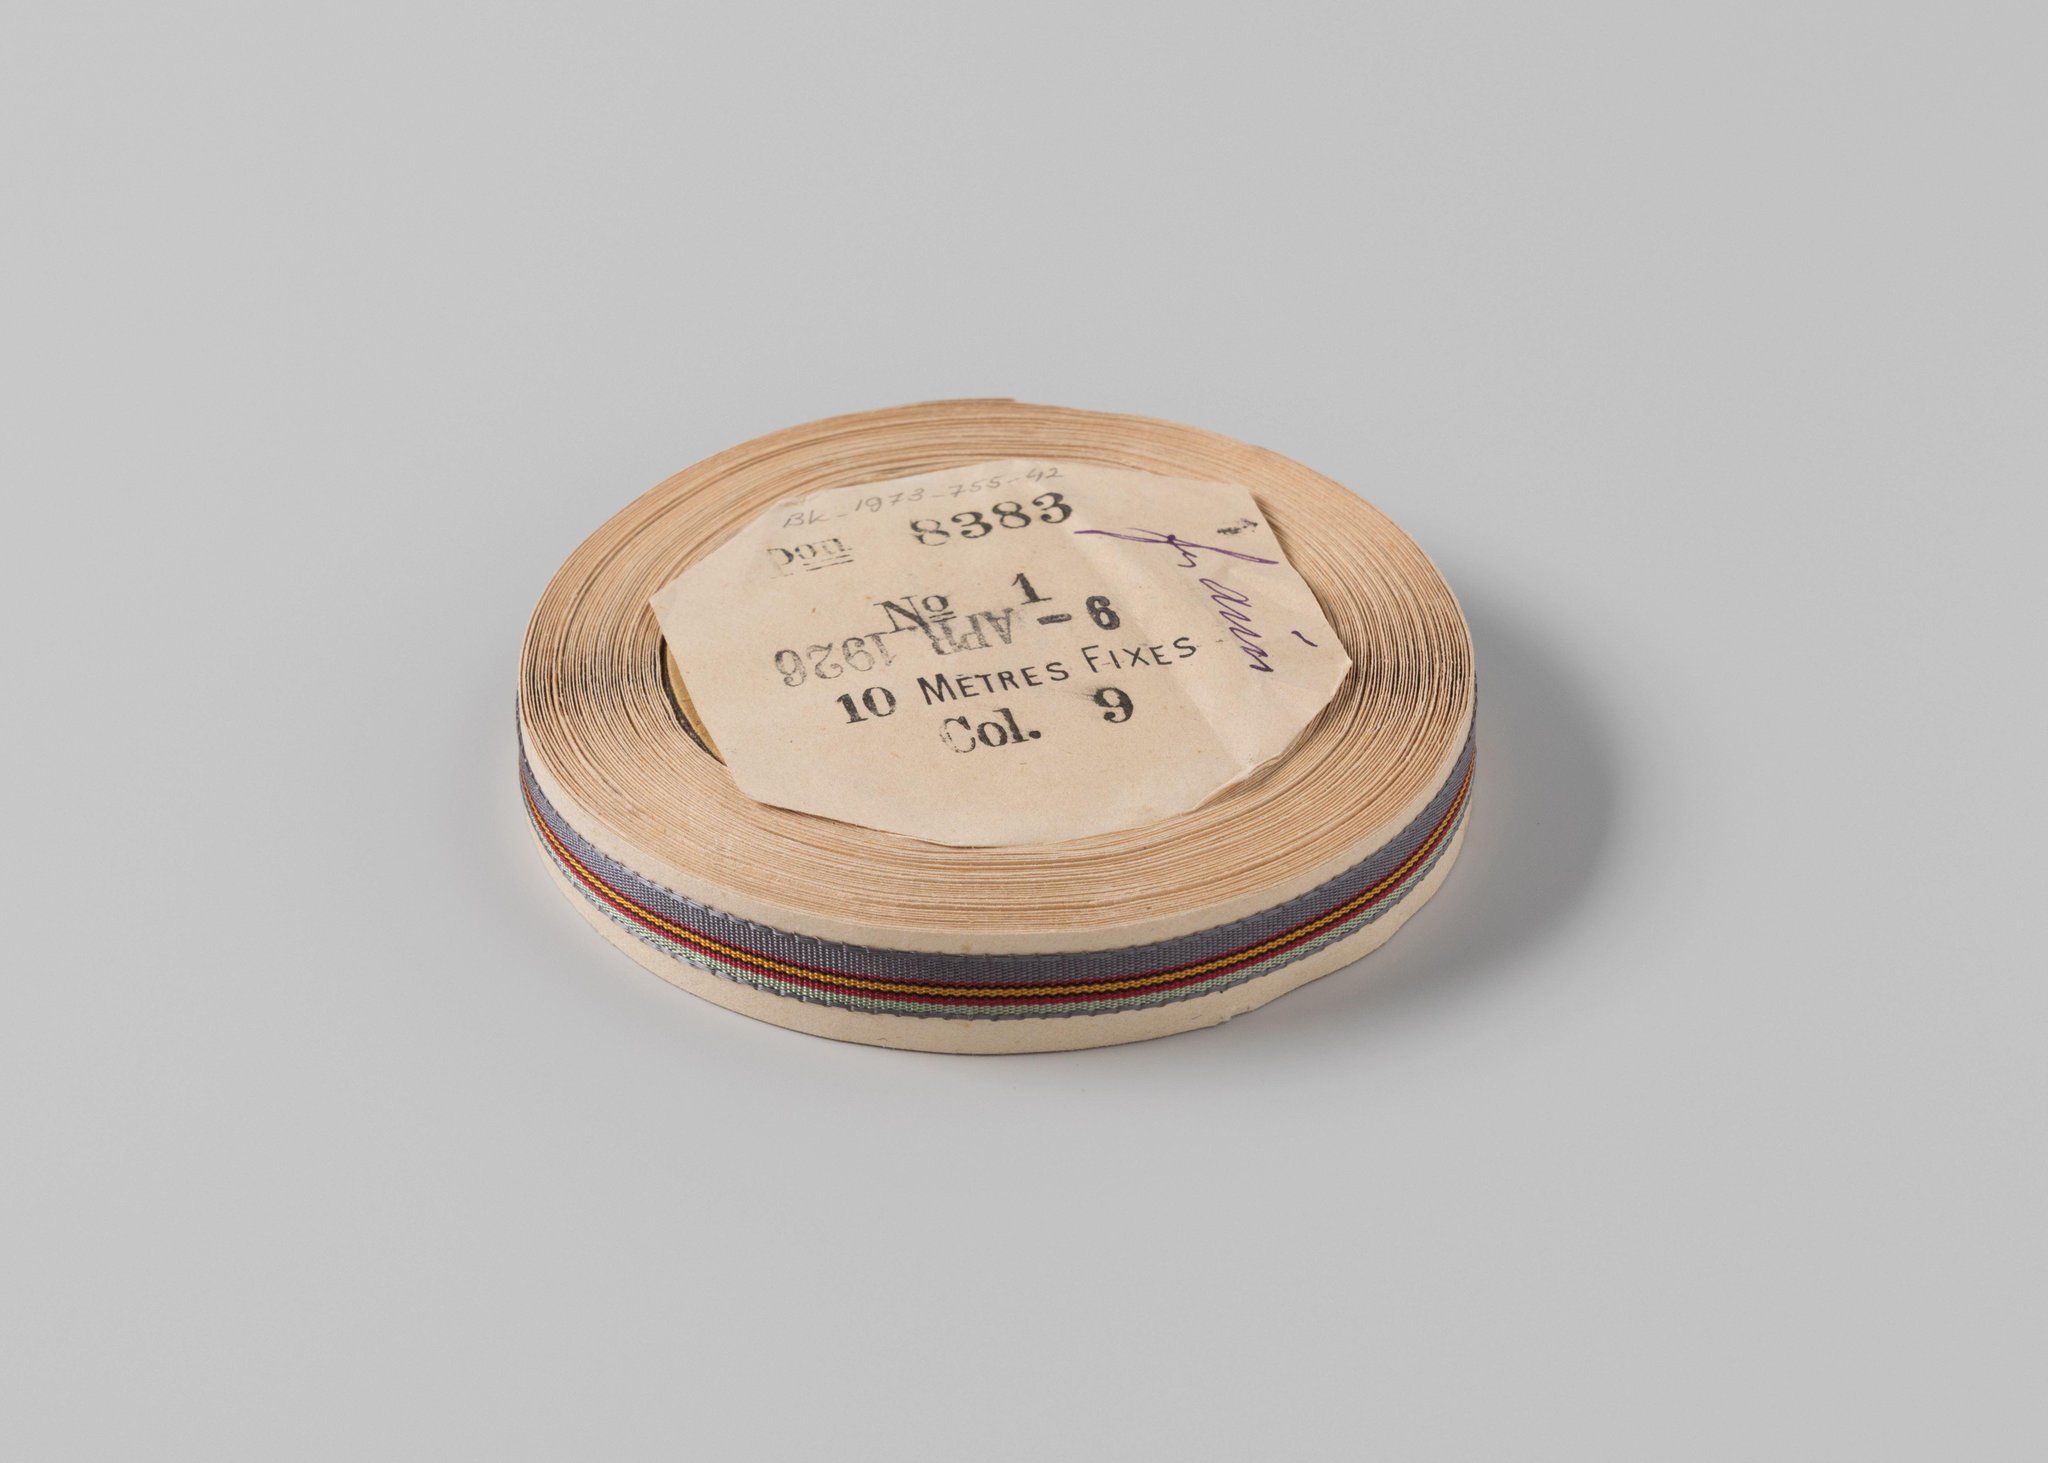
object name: braid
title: Lint op rol, gestreept, grijs met magenta, zwart, groen en oranje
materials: cardboard, paper, textile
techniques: weave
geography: nijmegen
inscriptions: number: ‘Pon 8383’, stamp: ‘9 - APR. 1926’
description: Lint op rol, gestreept, grijs met magenta, zwart, groen en oranje.